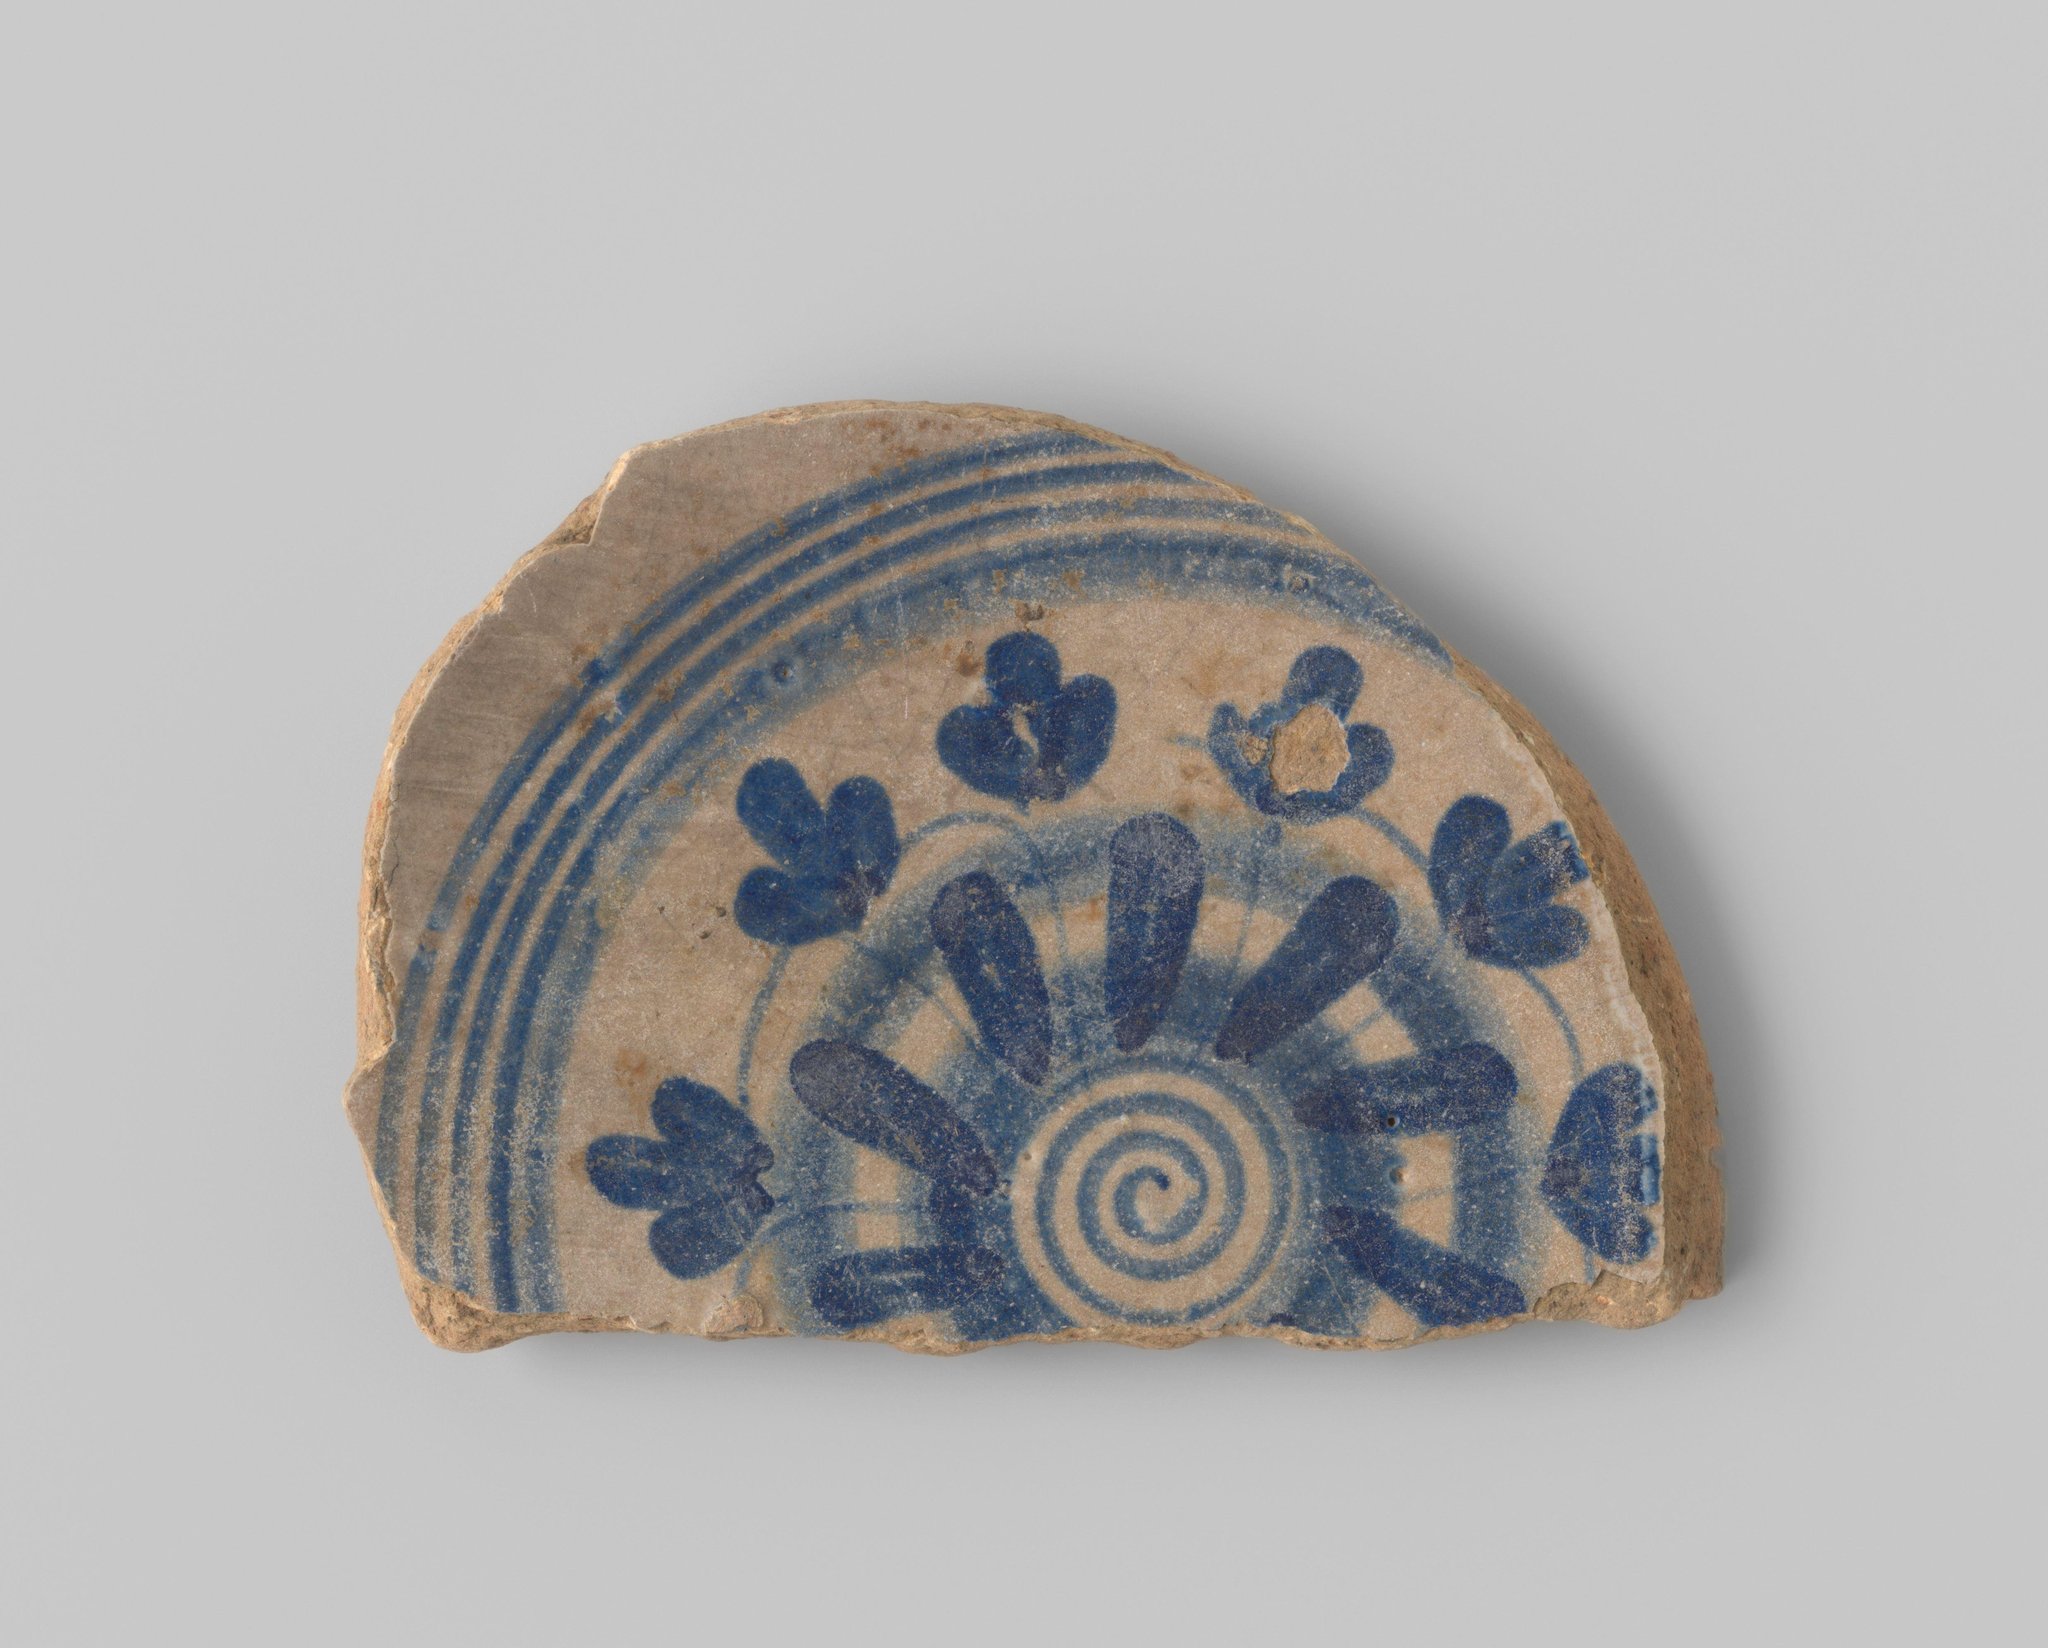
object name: fragment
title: Scherf van witbakkend aardewerk, aan de bovenzijde voorzien van een beschildering van een bloem in blauw op een witte ondergrond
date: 1500-1899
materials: earthenware, glaze